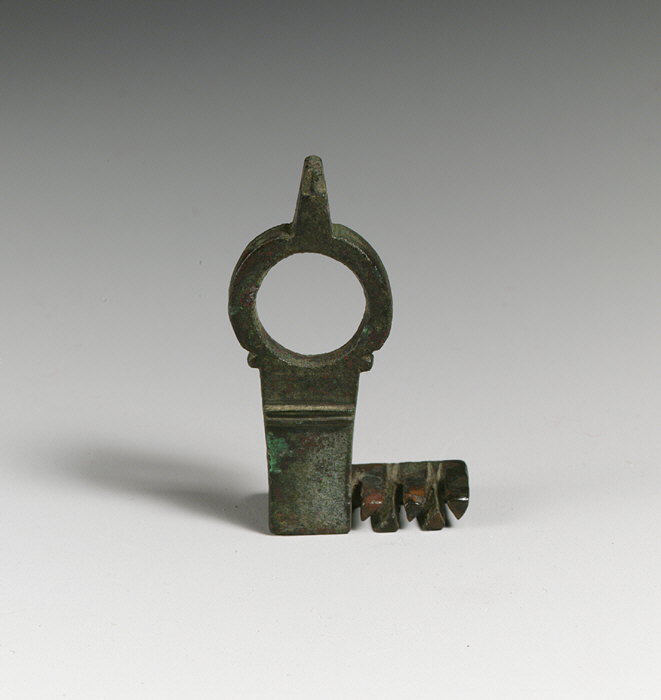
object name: key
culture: roman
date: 1-100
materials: bronze